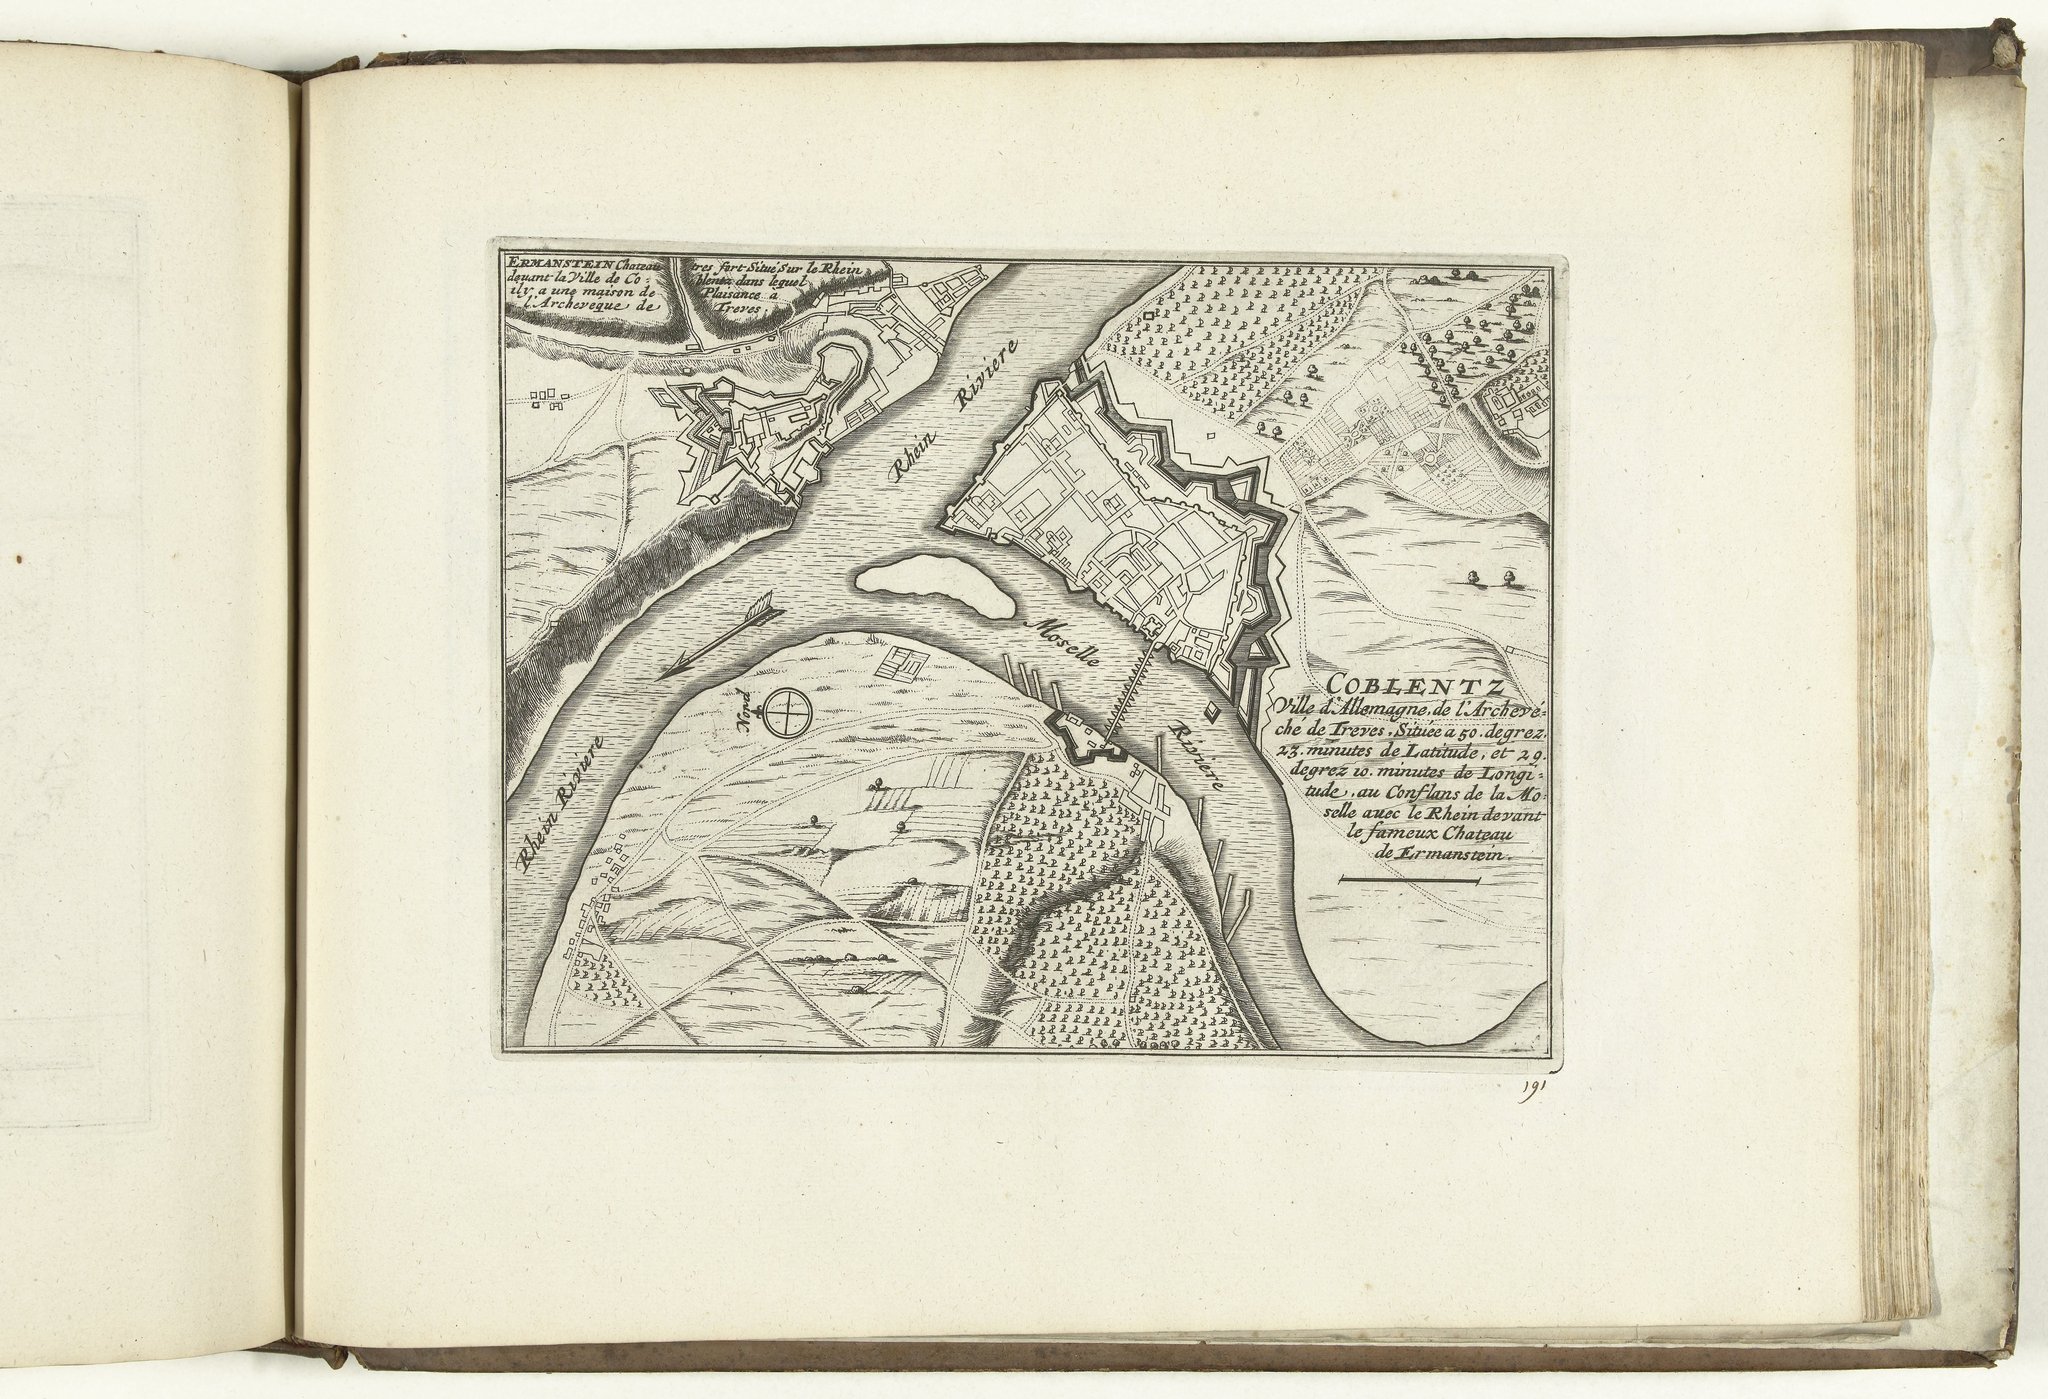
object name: print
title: Plattegrond van Koblenz, 1726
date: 1726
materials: paper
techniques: etching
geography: leiden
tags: fortress, maps of cities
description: Plattegrond van de versterkingen om de Duitse stad Koblenz. Plaat nr. 191 in deel VIII van het prentwerk: Les Forces de l'Europe, Asie, Afrique et Amerique ... Comme aussi les Cartes des Côtes de France et d'Espagne uit 1726, dit eerste deel met 238 met de hand genummerde platen van vermaarde sterke steden en vestingen in het kader van de Spaanse Successieoorlog 1701-1713. Voor het merendeel zijn deze platen gekopieerd naar de anonieme Franse platen van vermaarde sterke steden en vestingen: in Les forces de l'Europe en in: Le theatre de la guerre, dans les Pays-Bas, beide oorspronkelijk uitgegeven door Nicolas de Fer te Parijs (1693-1697) in het kader van de Negenjarige Oorlog. Titel en opschriften in het Frans. Rechtsonder sporen van het weggepolijste nummer: 128.